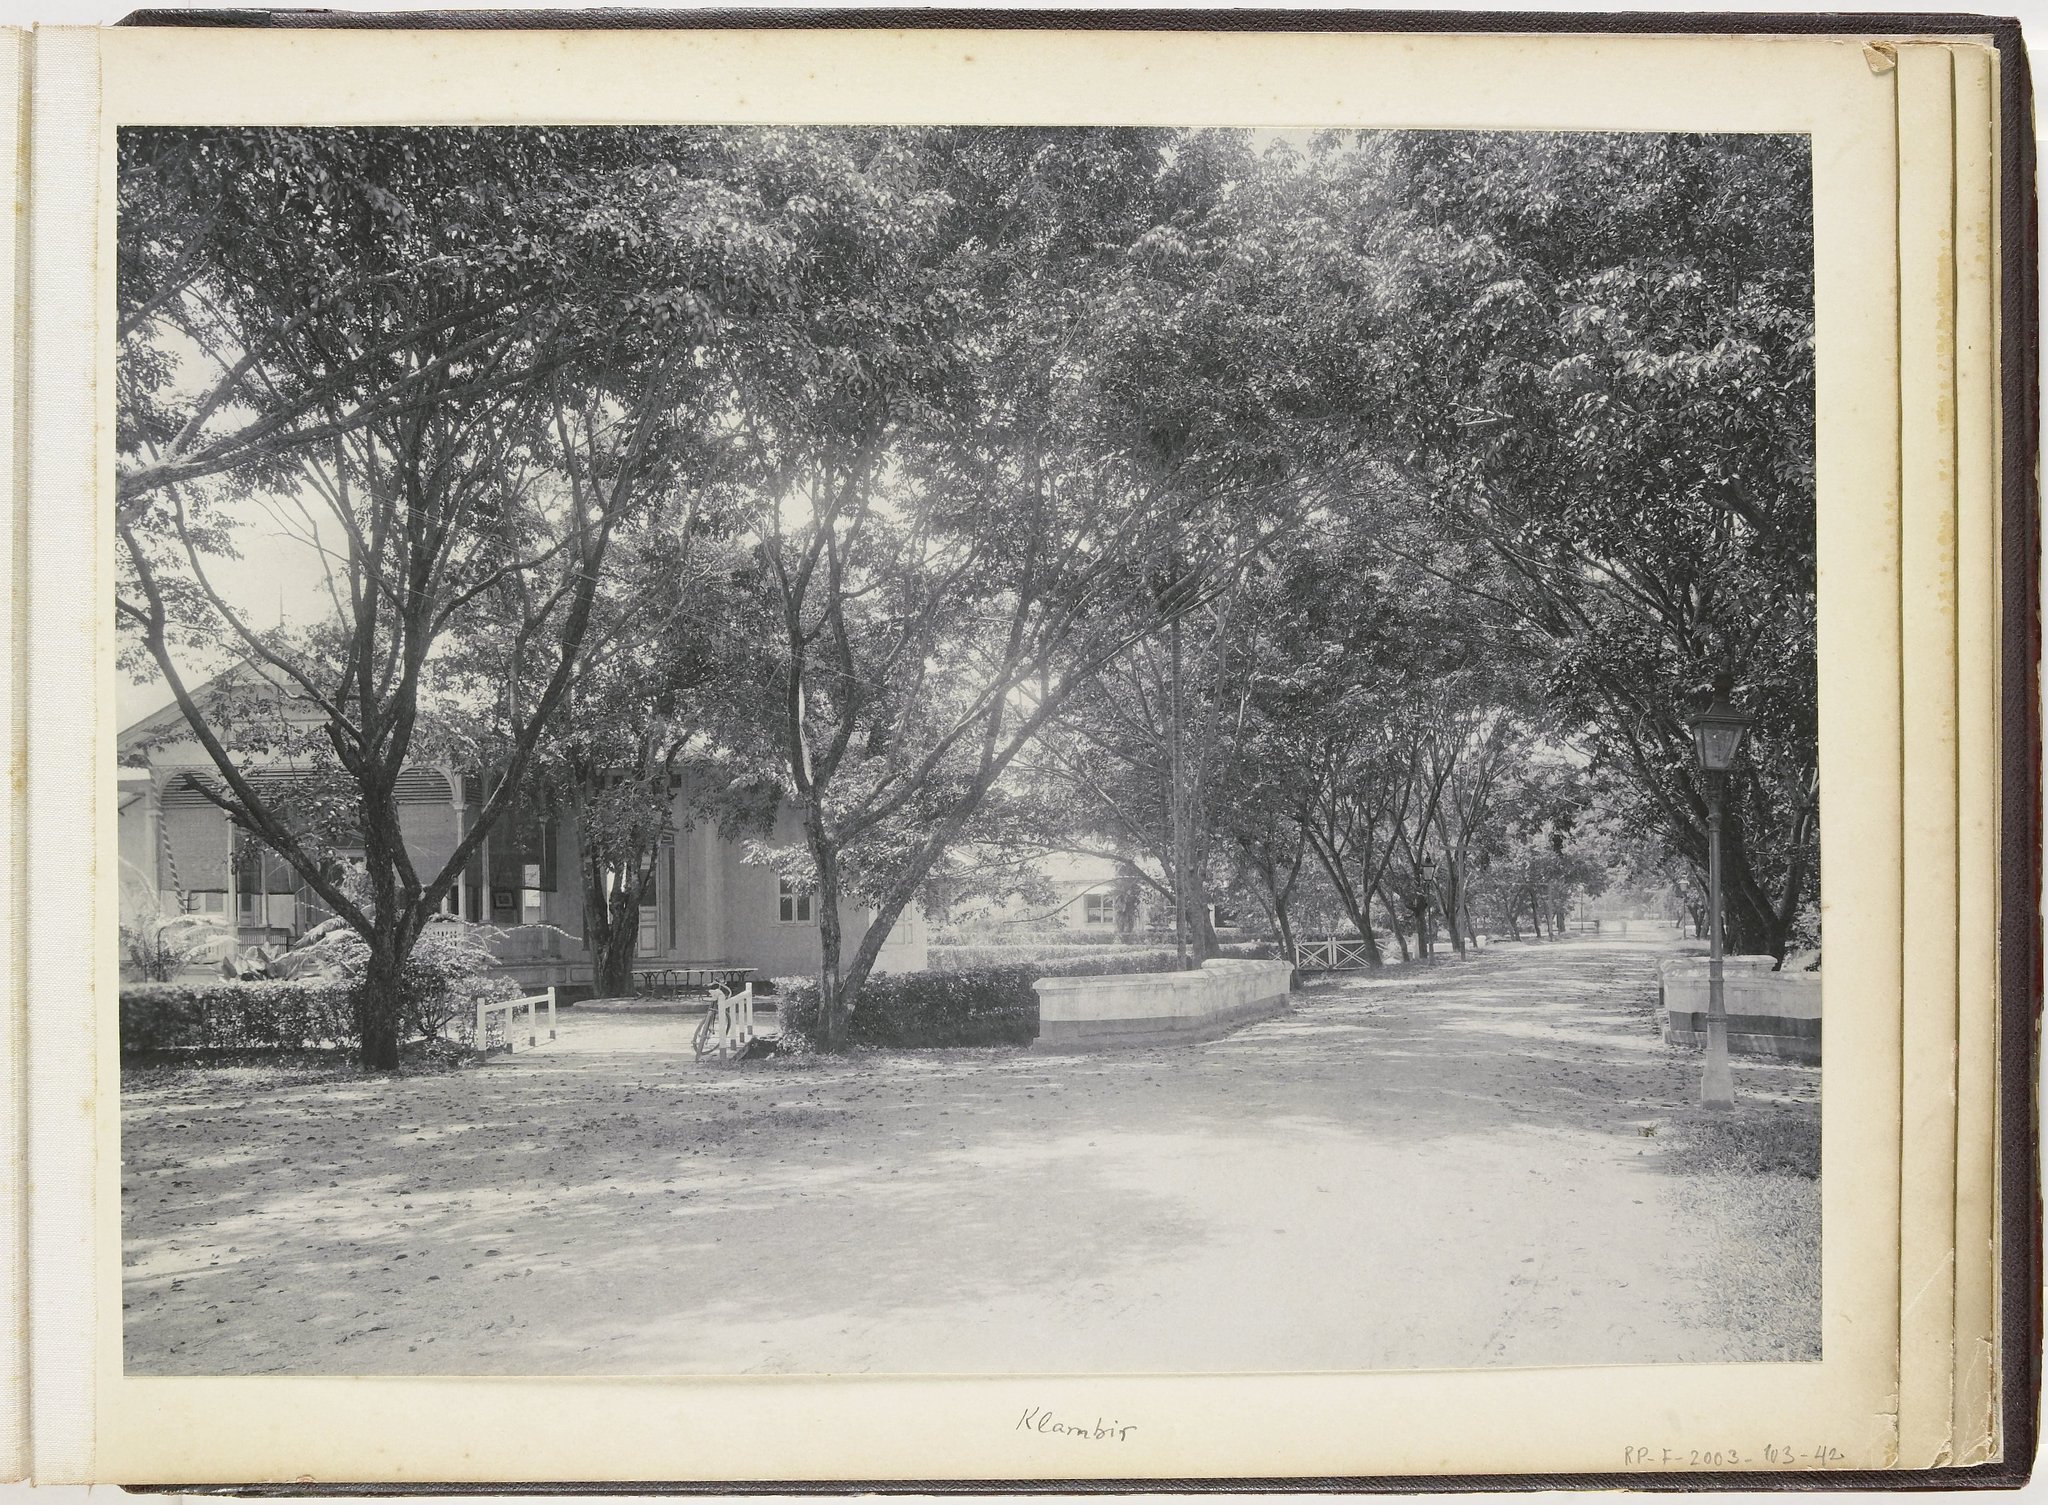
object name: photograph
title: Gezicht op Sociëteit Klambir, Langkat Sumatra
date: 1890-1900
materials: cardboard, paper, photographic support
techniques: platinum process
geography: bindjai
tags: sumatra